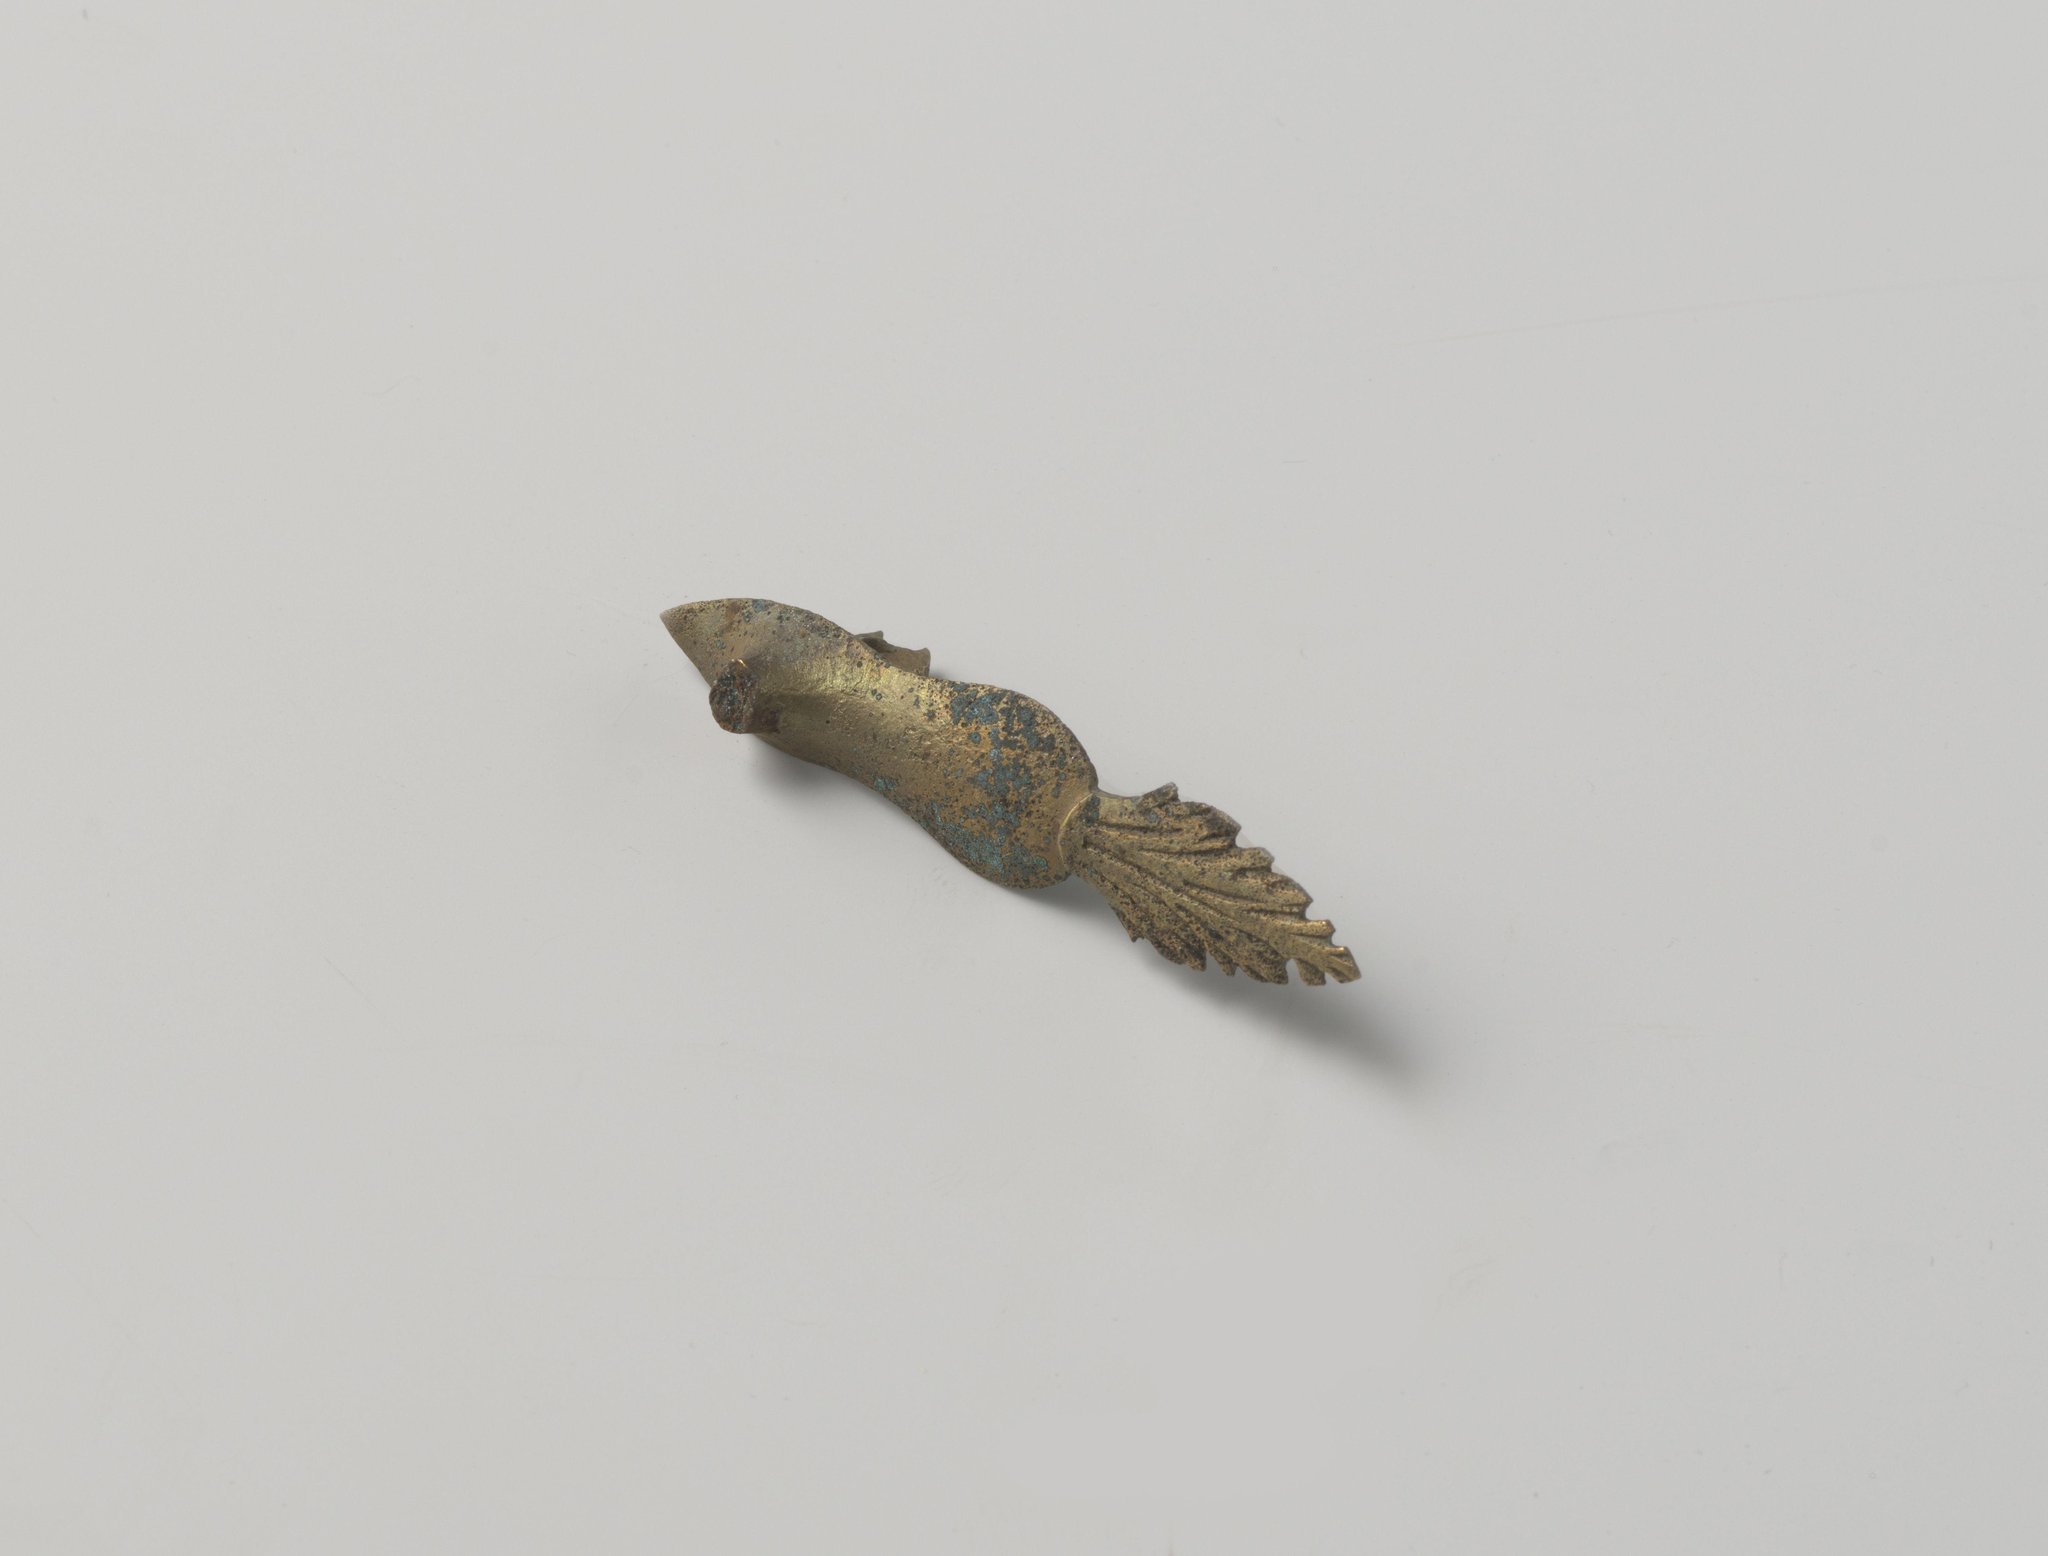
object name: trigger guard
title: Fragment van een trekkerbeugel uit het wrak van de Oostindiëvaarder Hollandia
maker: Anonymous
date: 1700-1743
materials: copper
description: Fragment van een trekkerbeugel van een van een musket.